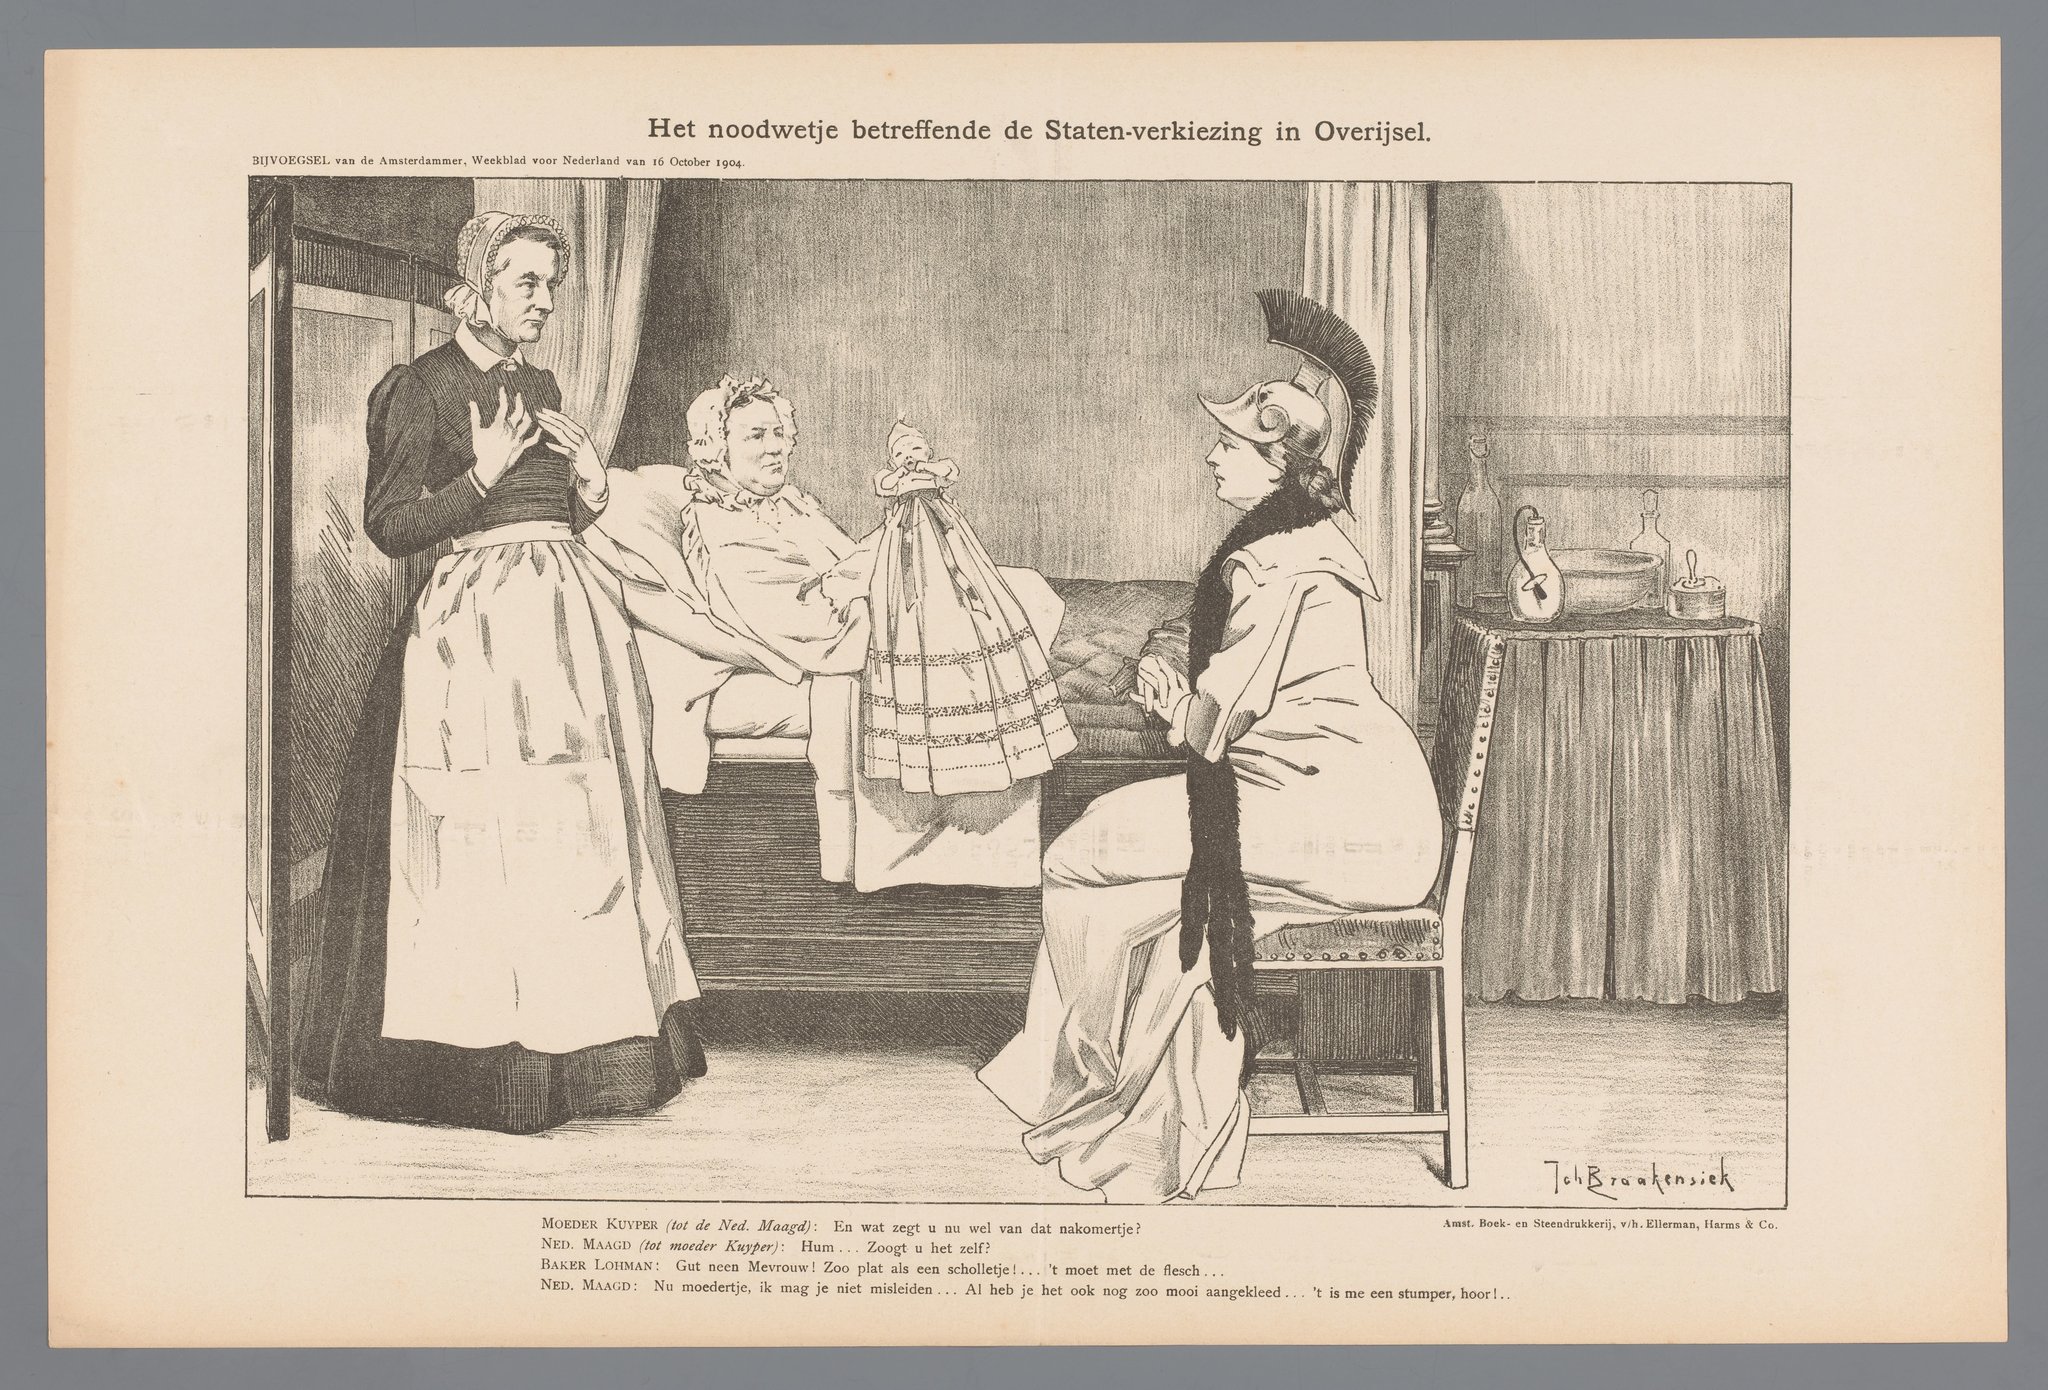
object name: cartoon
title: Het noodwetje betreffende de Staten-verkiezing in Overijssel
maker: johan braakensiek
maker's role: draughtsman, print maker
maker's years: 1858-1940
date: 1904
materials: paper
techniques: lithograph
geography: amsterdam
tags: jonkheer alexander frederik de savornin lohman, the hague, abraham kuyper, nursing, suckling, visiting the new mother, lying-in visit, personifications of countries, nations, states, districts, etc. (+ nation; national), political caricatures and satires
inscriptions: date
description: Prent uit het bijvoegsel van: De Amsterdammer. Weekblad voor Nederland, 16 oktober 1904.